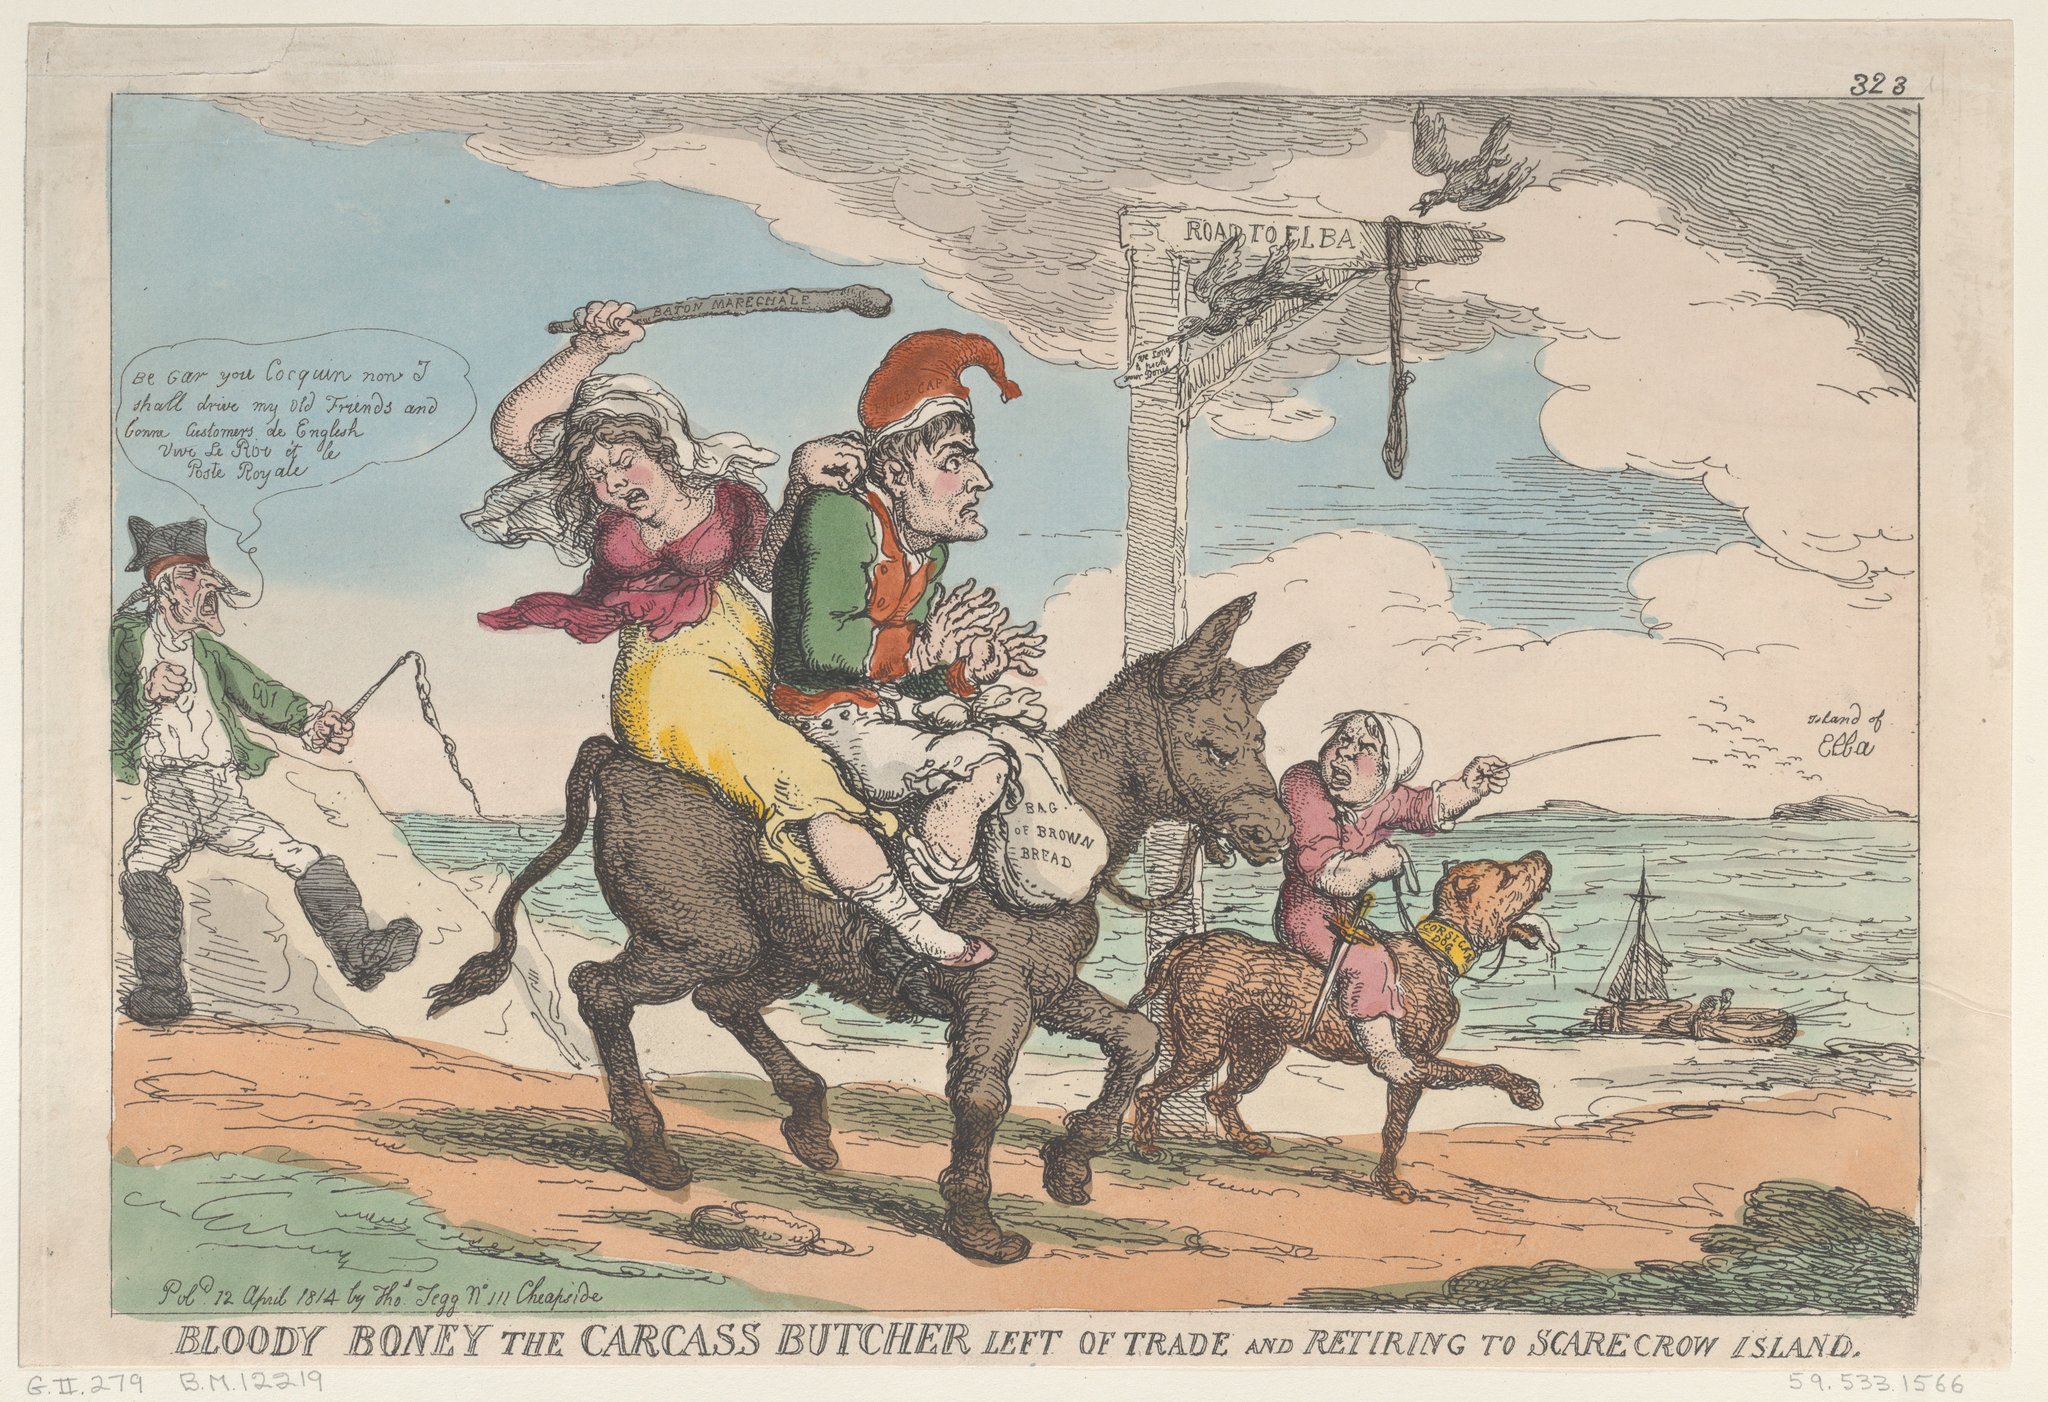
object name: print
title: Bloody Boney the Carcass Butcher Left of Trade and Retiring to Scarecrow Island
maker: thomas rowlandson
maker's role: artist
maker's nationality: british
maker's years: 1757-1827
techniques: etching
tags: satire,napoleon i,men,women,dogs,donkeys